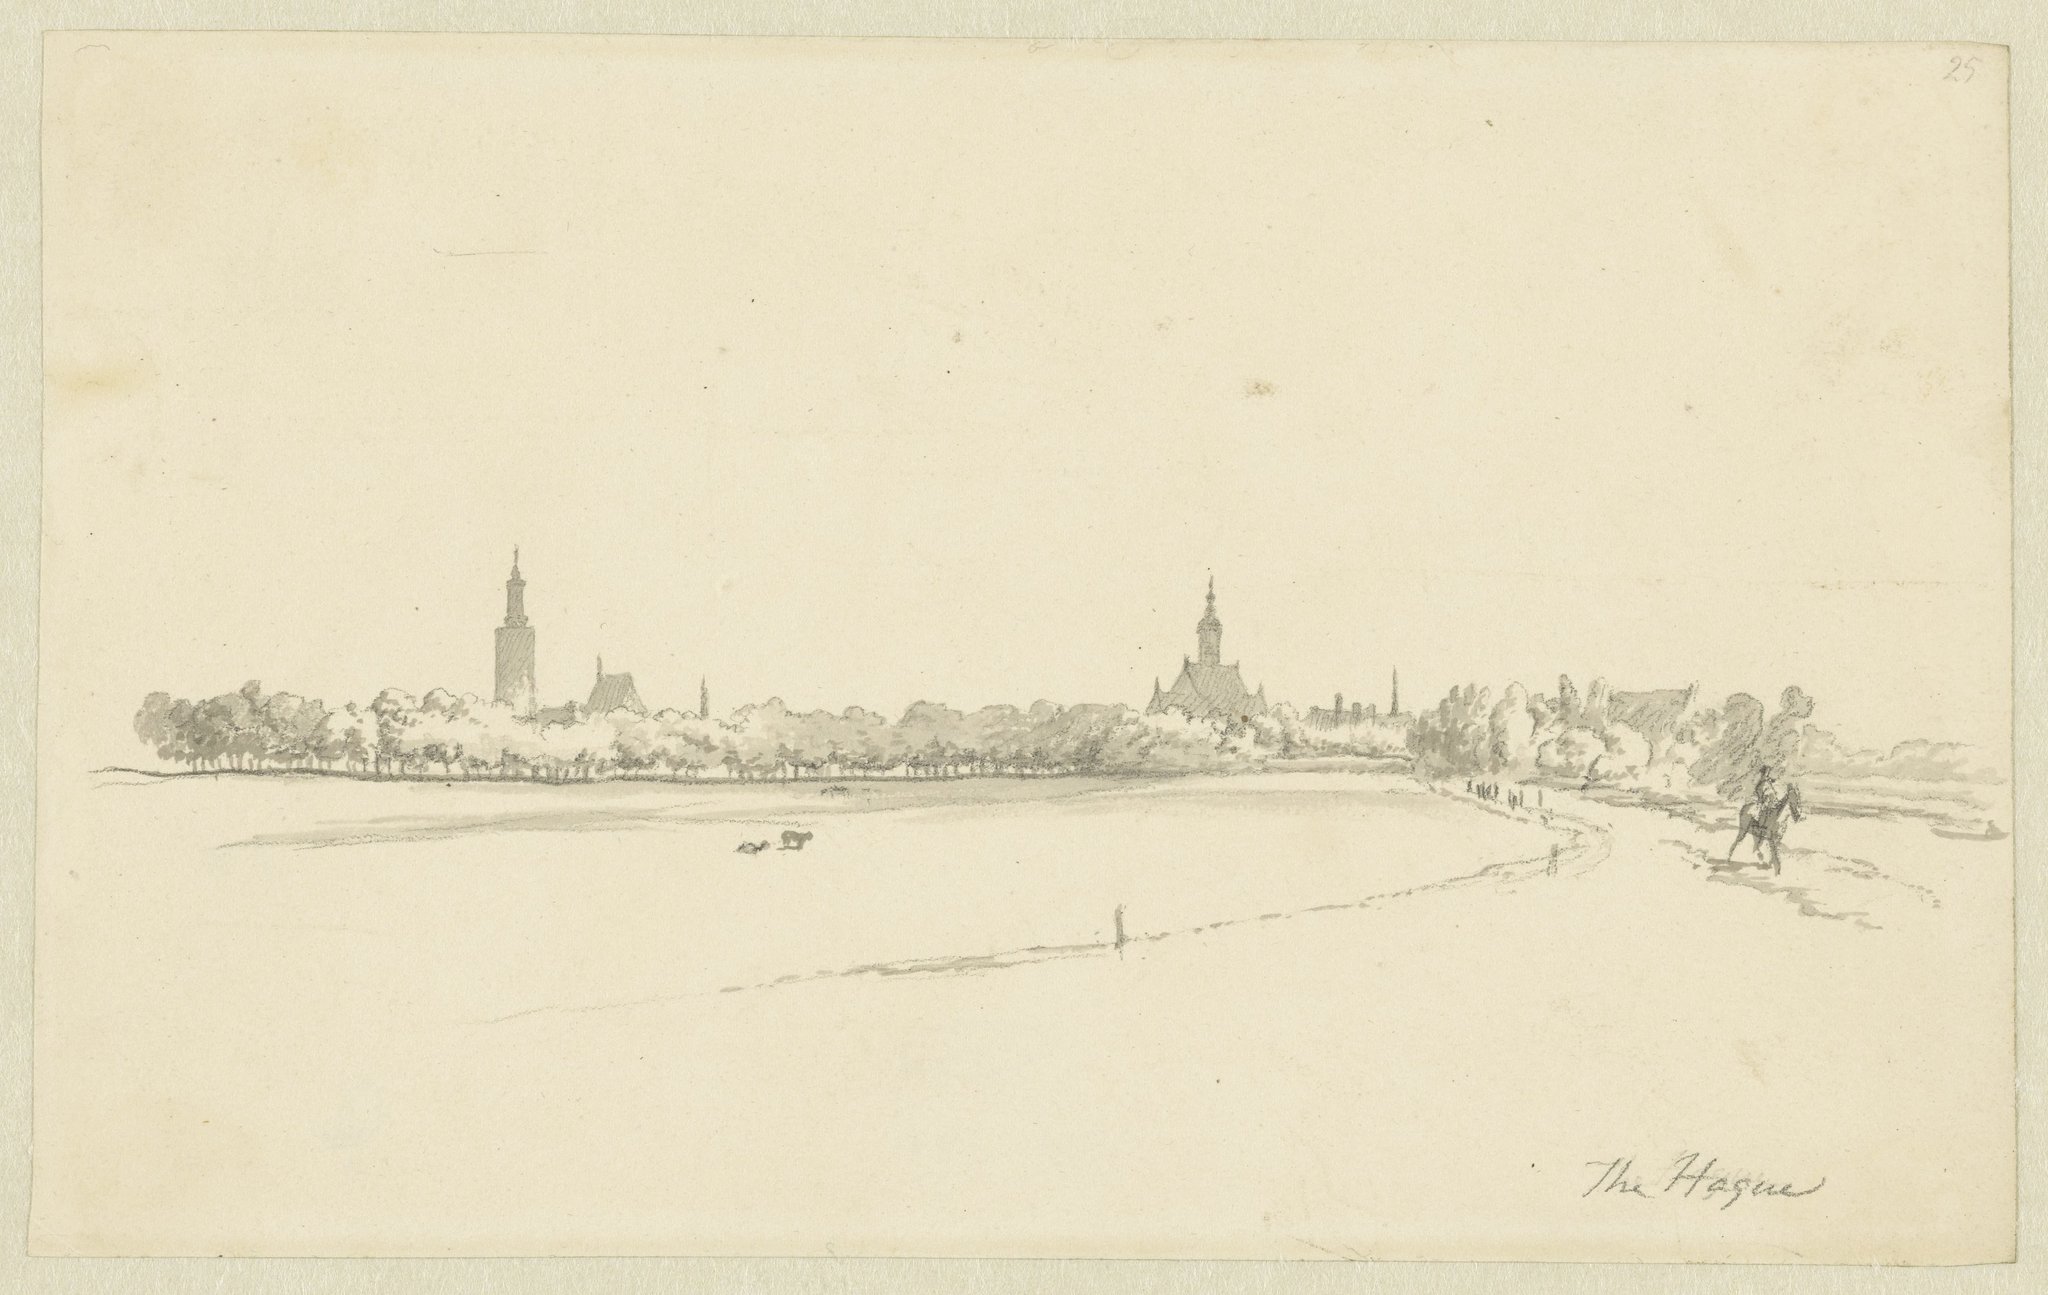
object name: design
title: Ontwerpen voor reeks aquatints Sketches in Flanders and Holland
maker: robert hills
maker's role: draughtsman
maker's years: 1769-1844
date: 1811-1816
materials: paper, pencil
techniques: brush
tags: outskirts of city (+ city (-scape) with figures, staffage), prospect of city, town panorama, silhouette of city, the hague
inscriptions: inscription: ‘The Hague’